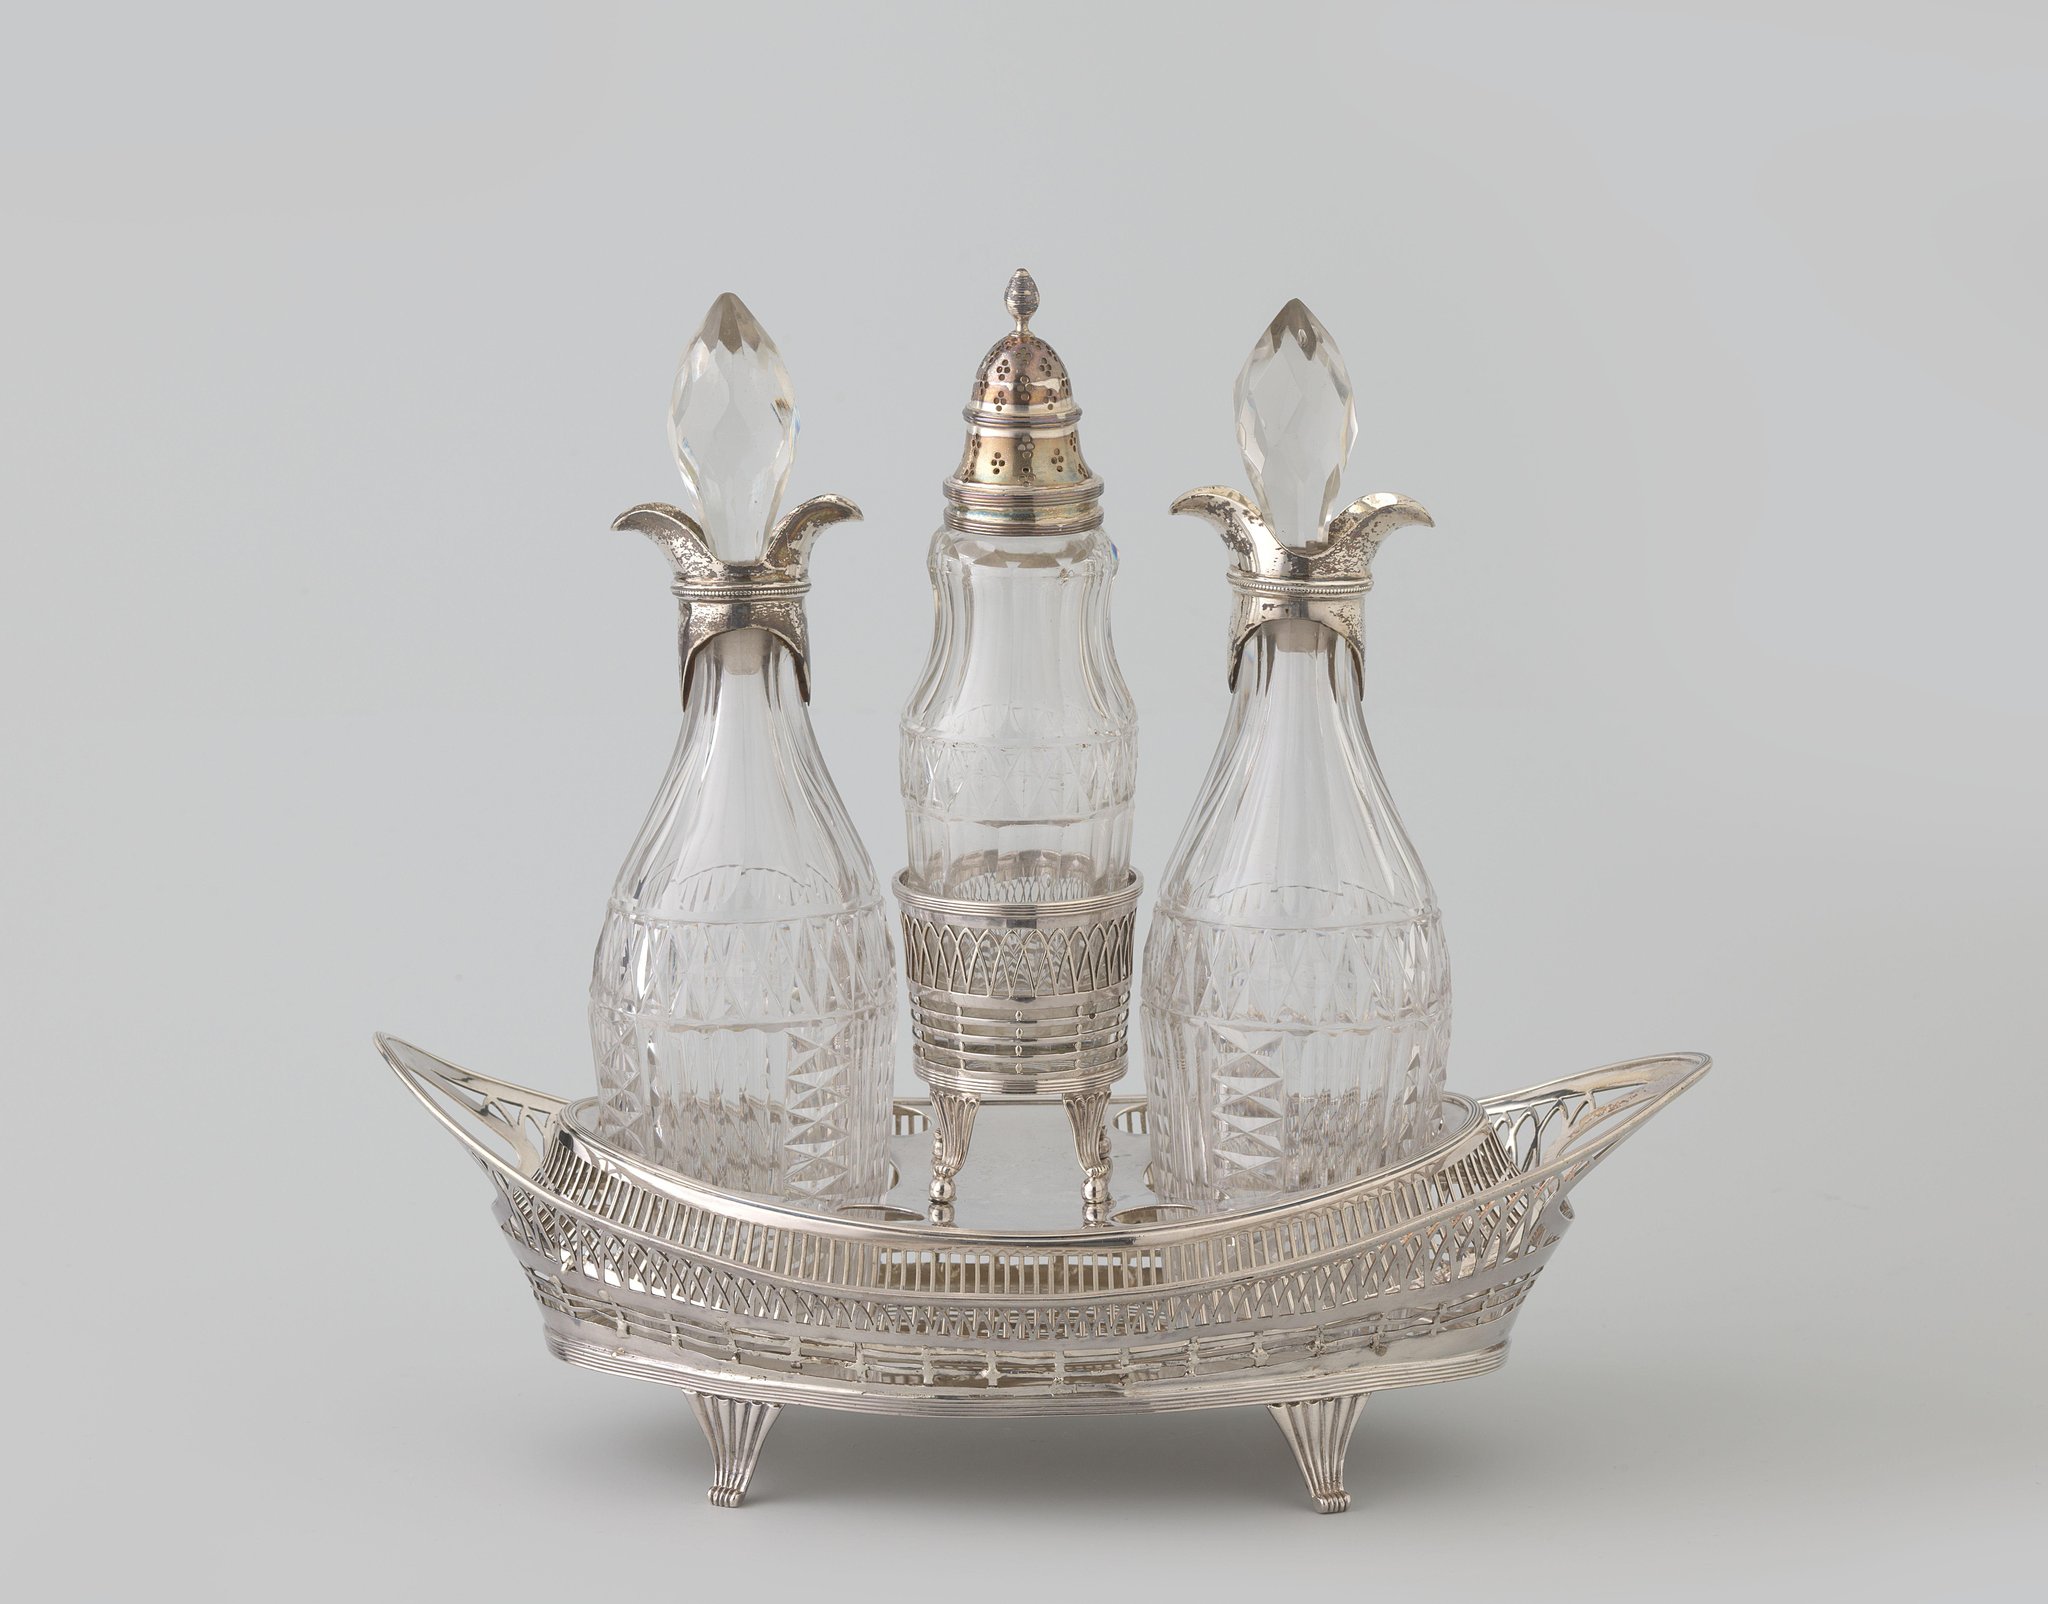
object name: cruet set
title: Strooibus behorende bij olie-en azijnstel bestaande uit twee flessen en een strooibus in spitsovale houder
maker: hendrik smits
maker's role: silversmith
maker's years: 1772-1841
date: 1803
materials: glass, silver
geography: amsterdam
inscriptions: mark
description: Glazen peperstrooier met een meervoudig gewelfde, door twee filet- en een profielrand gelede, zilveren dop, die is opengewerkt met een patroon van puntjes, en wordt bekroond door een pijnappelvormige, geribde knop. De strooier past in een cilindervormige houder die op het inzetstuk van het olie- en azijnstel is geschroefd.